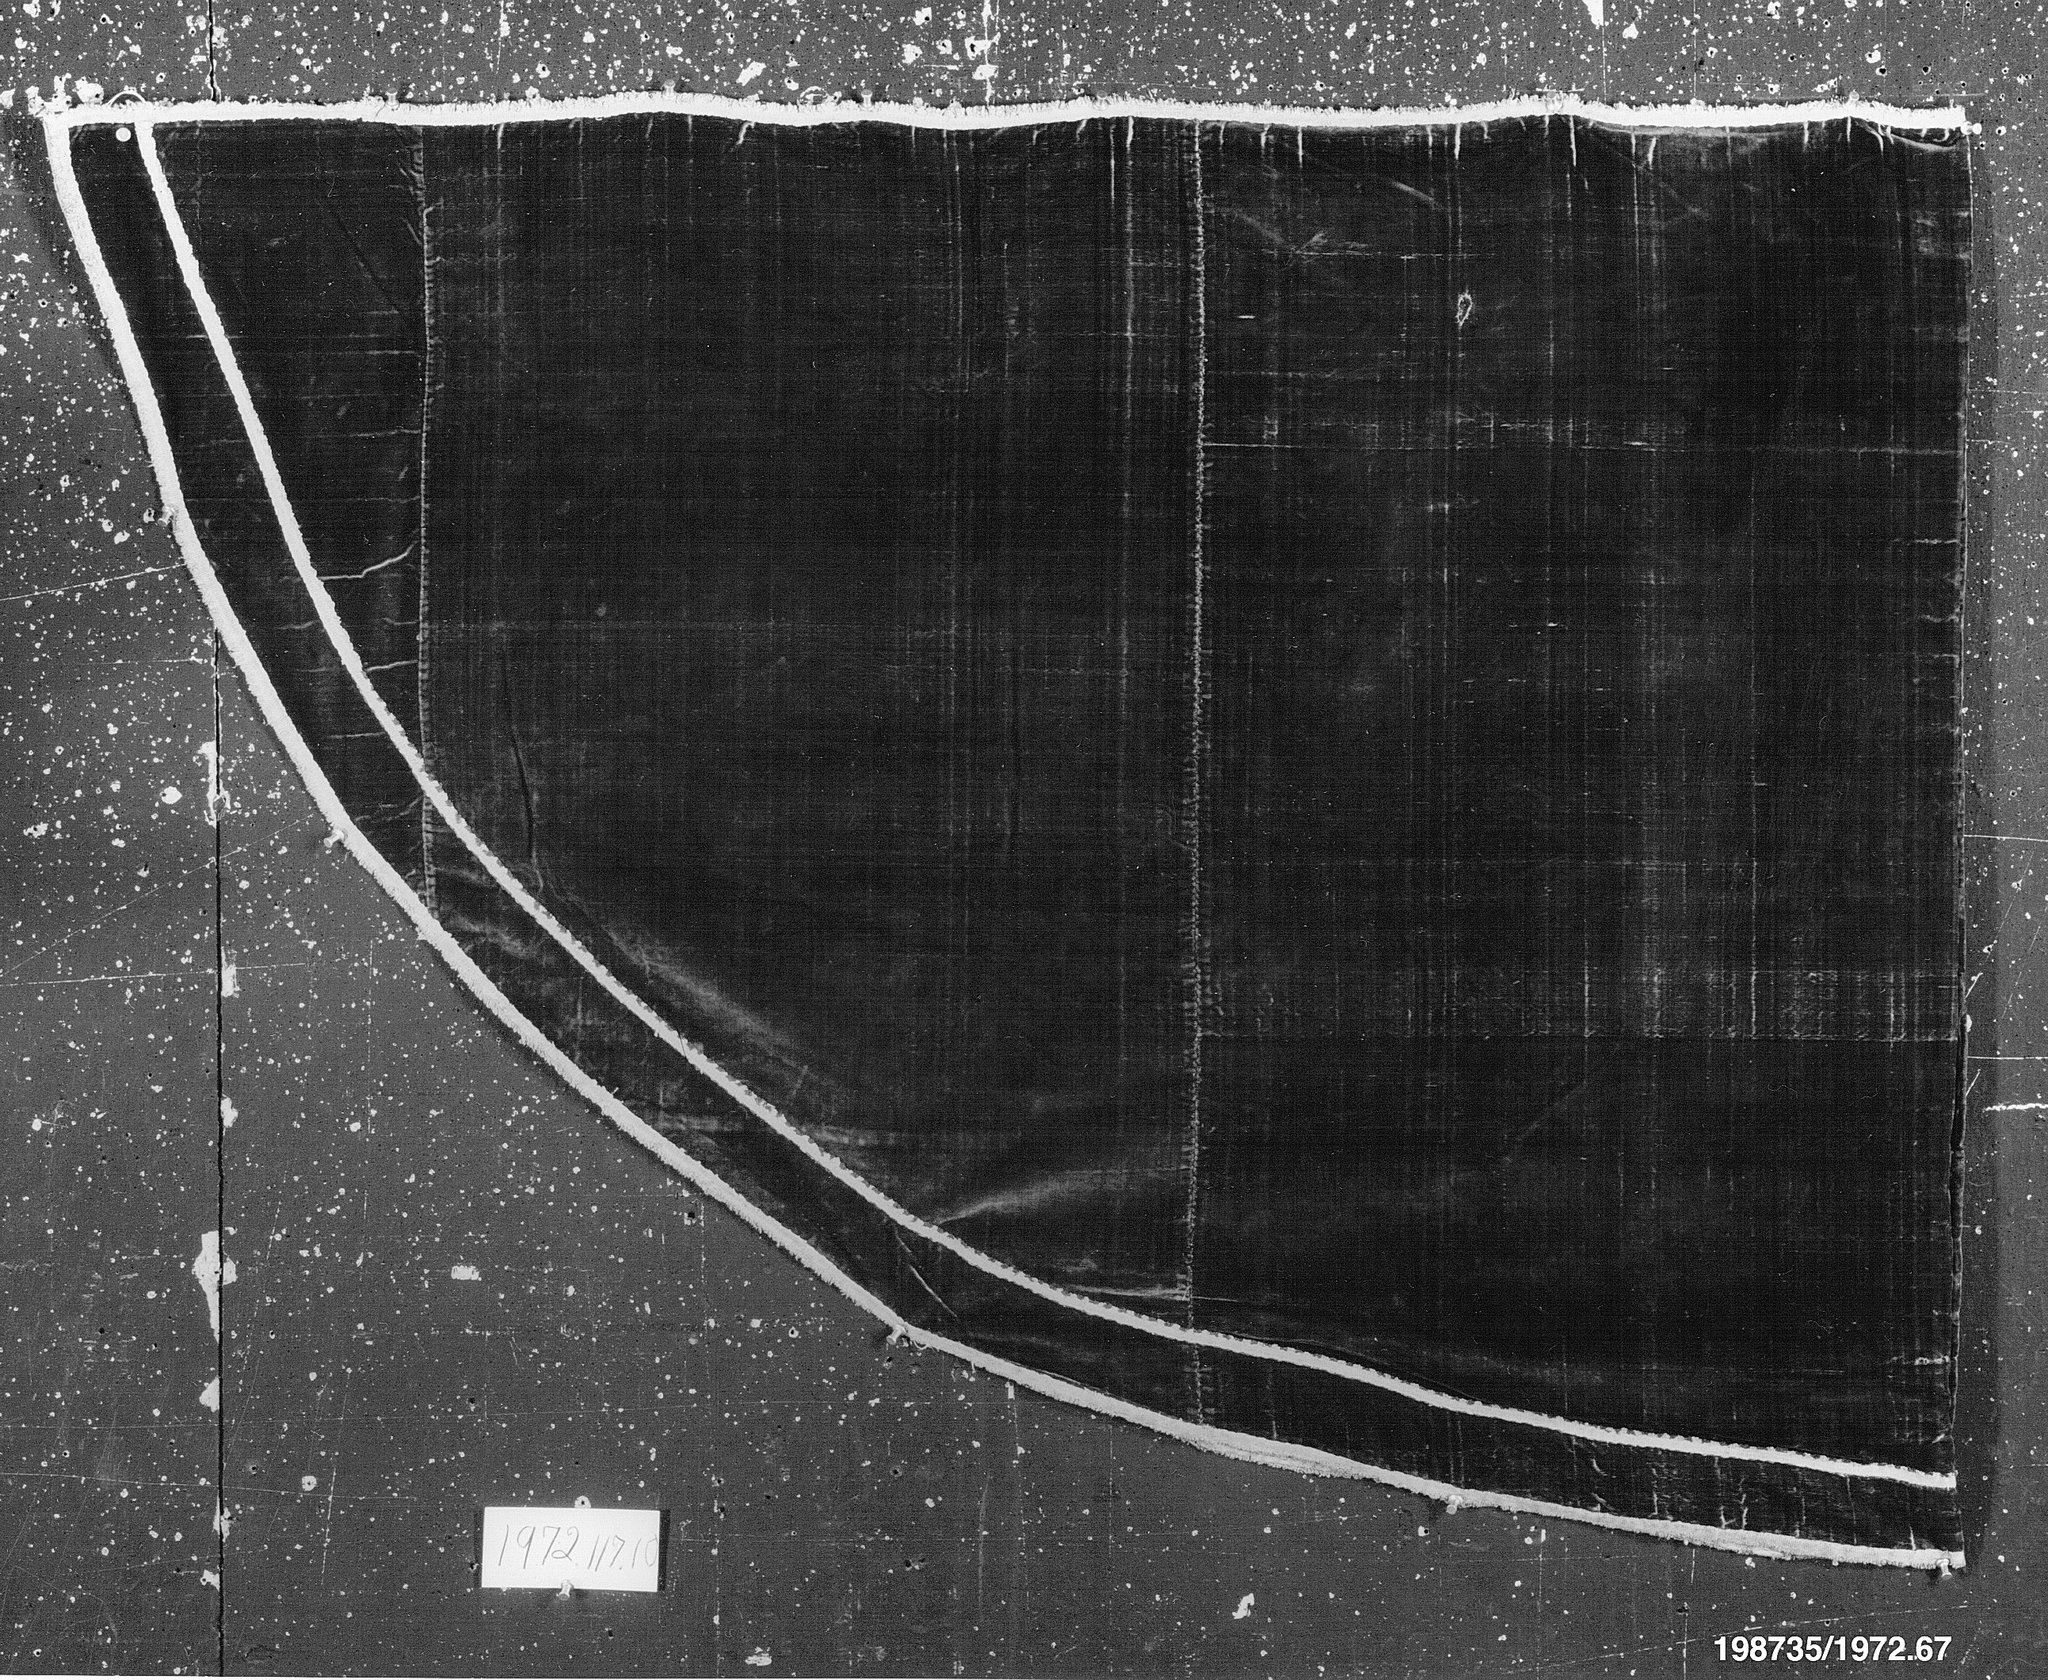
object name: cope shape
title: Cope-shape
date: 1601-1700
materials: linen, silk